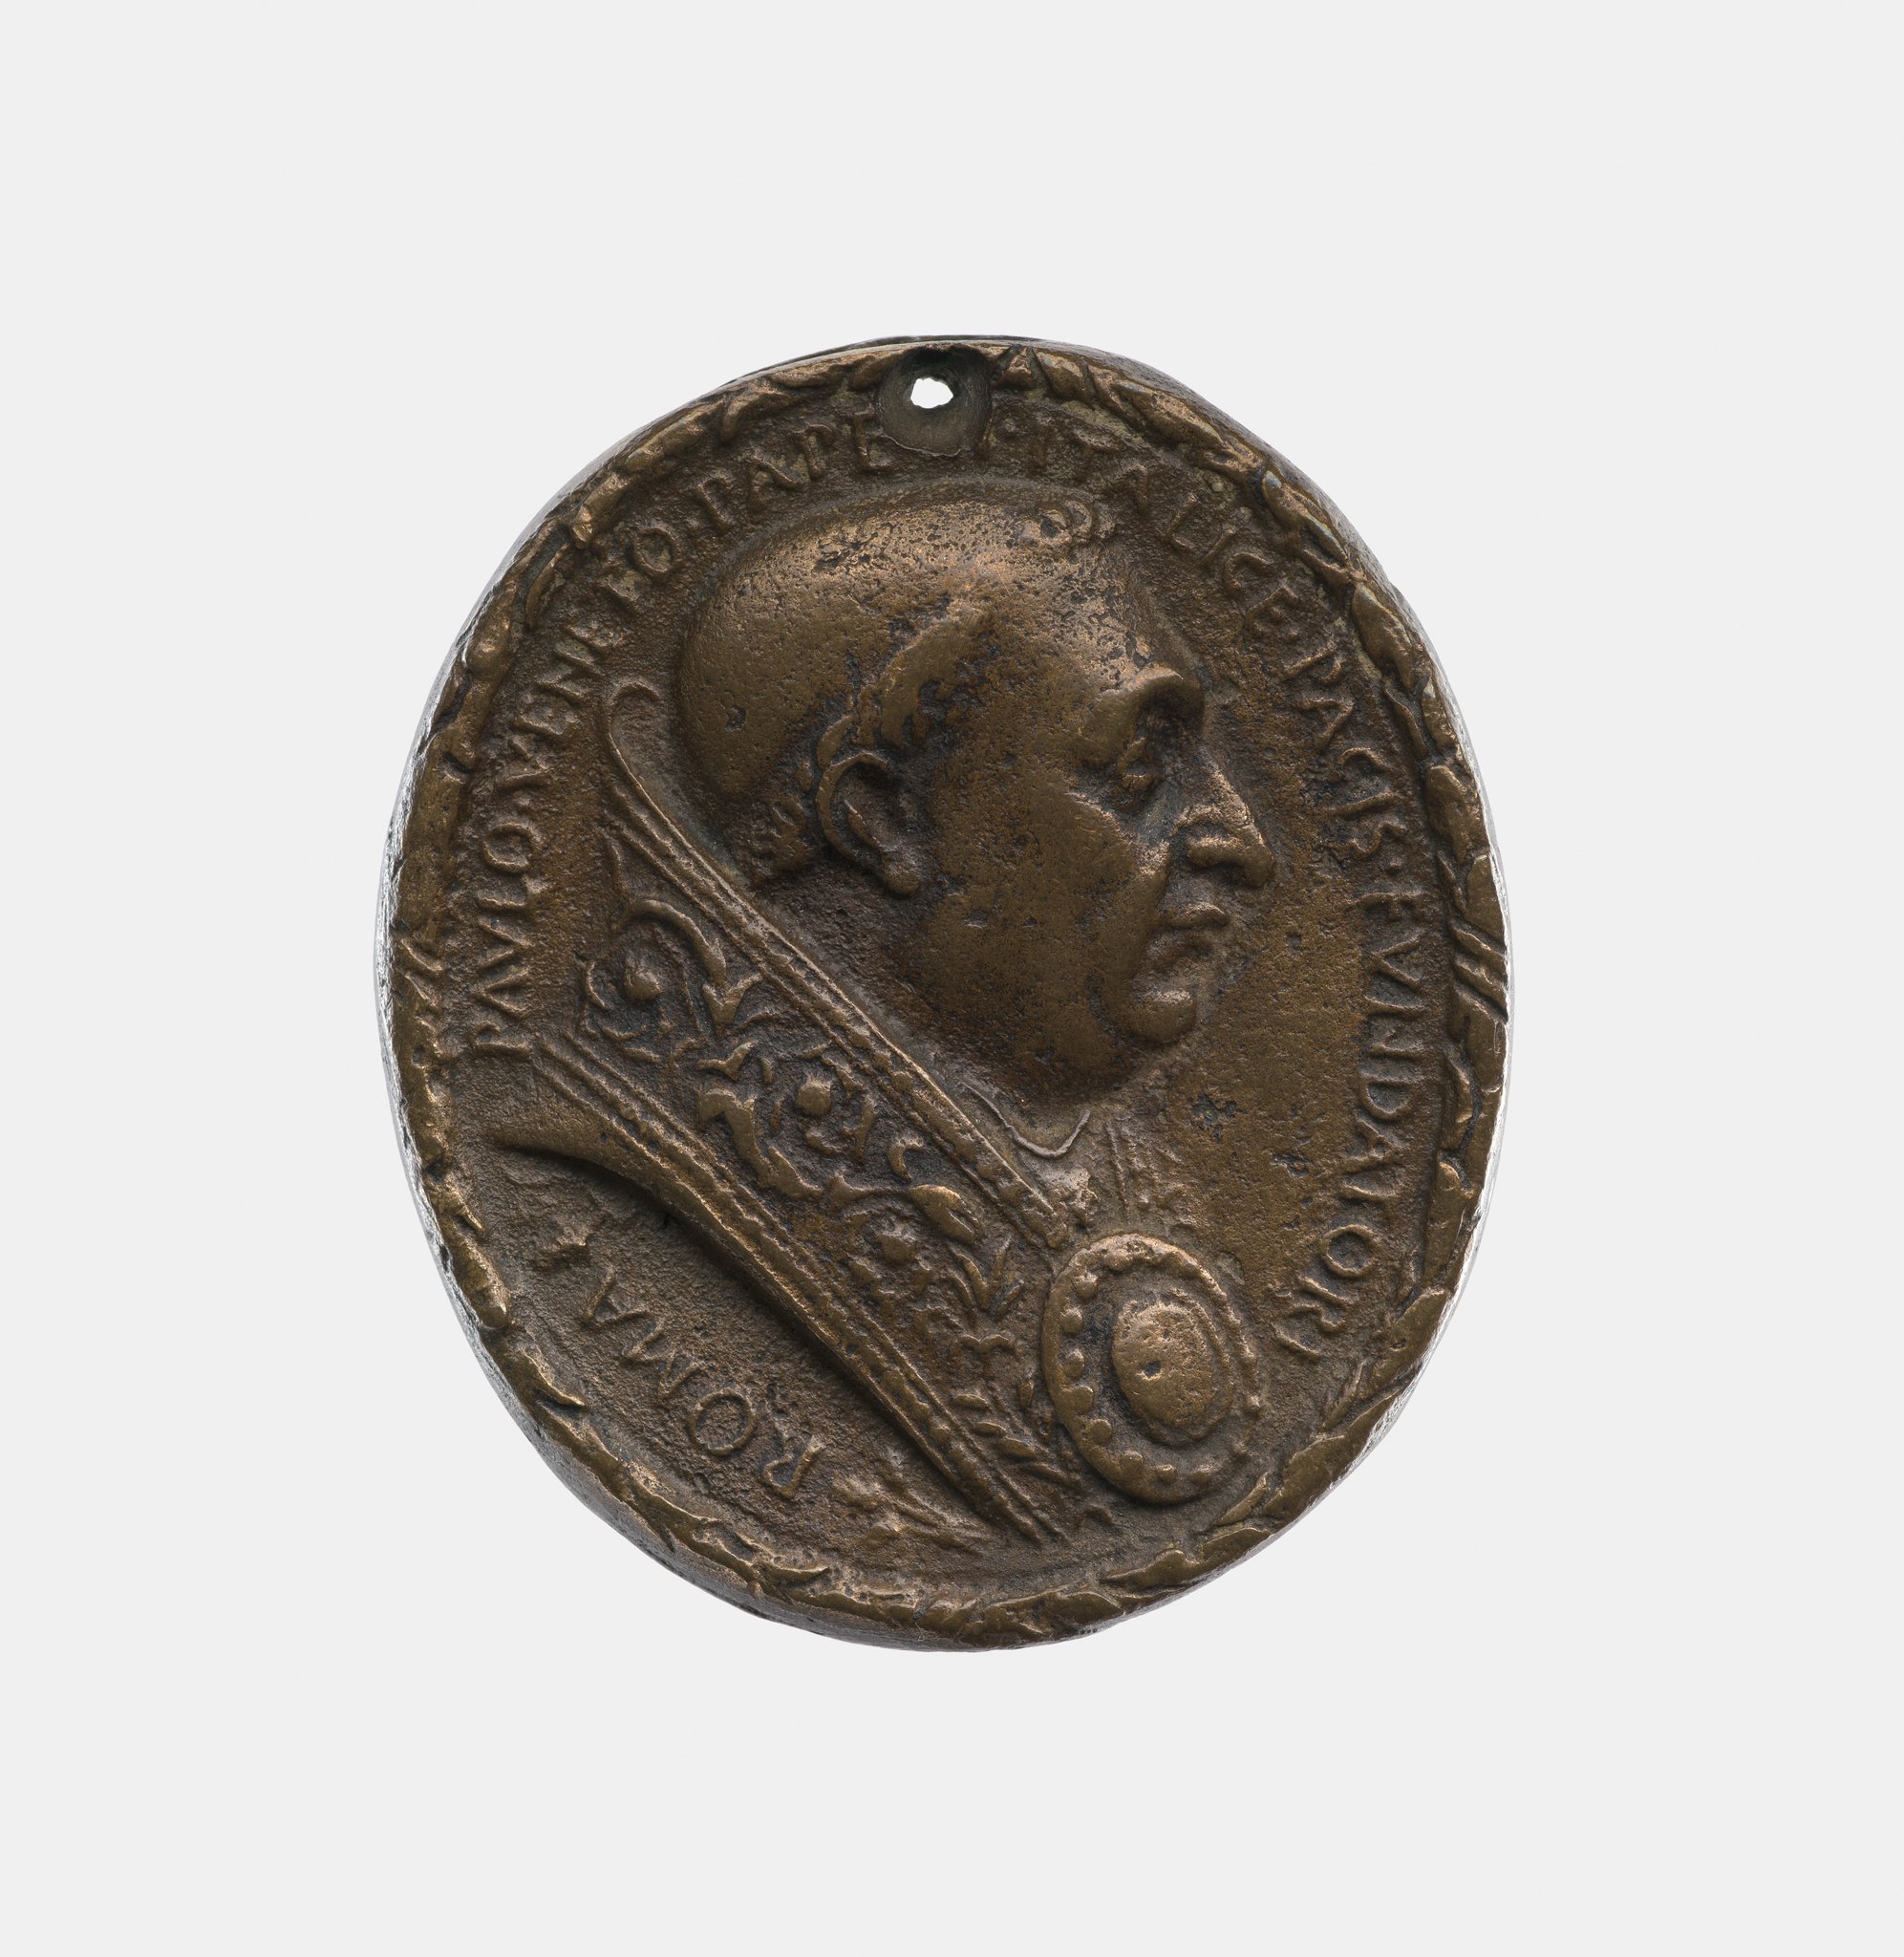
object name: medal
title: Pope Paul II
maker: cristoforo di geremia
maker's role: artist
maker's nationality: italian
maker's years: 1456-1476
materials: bronze